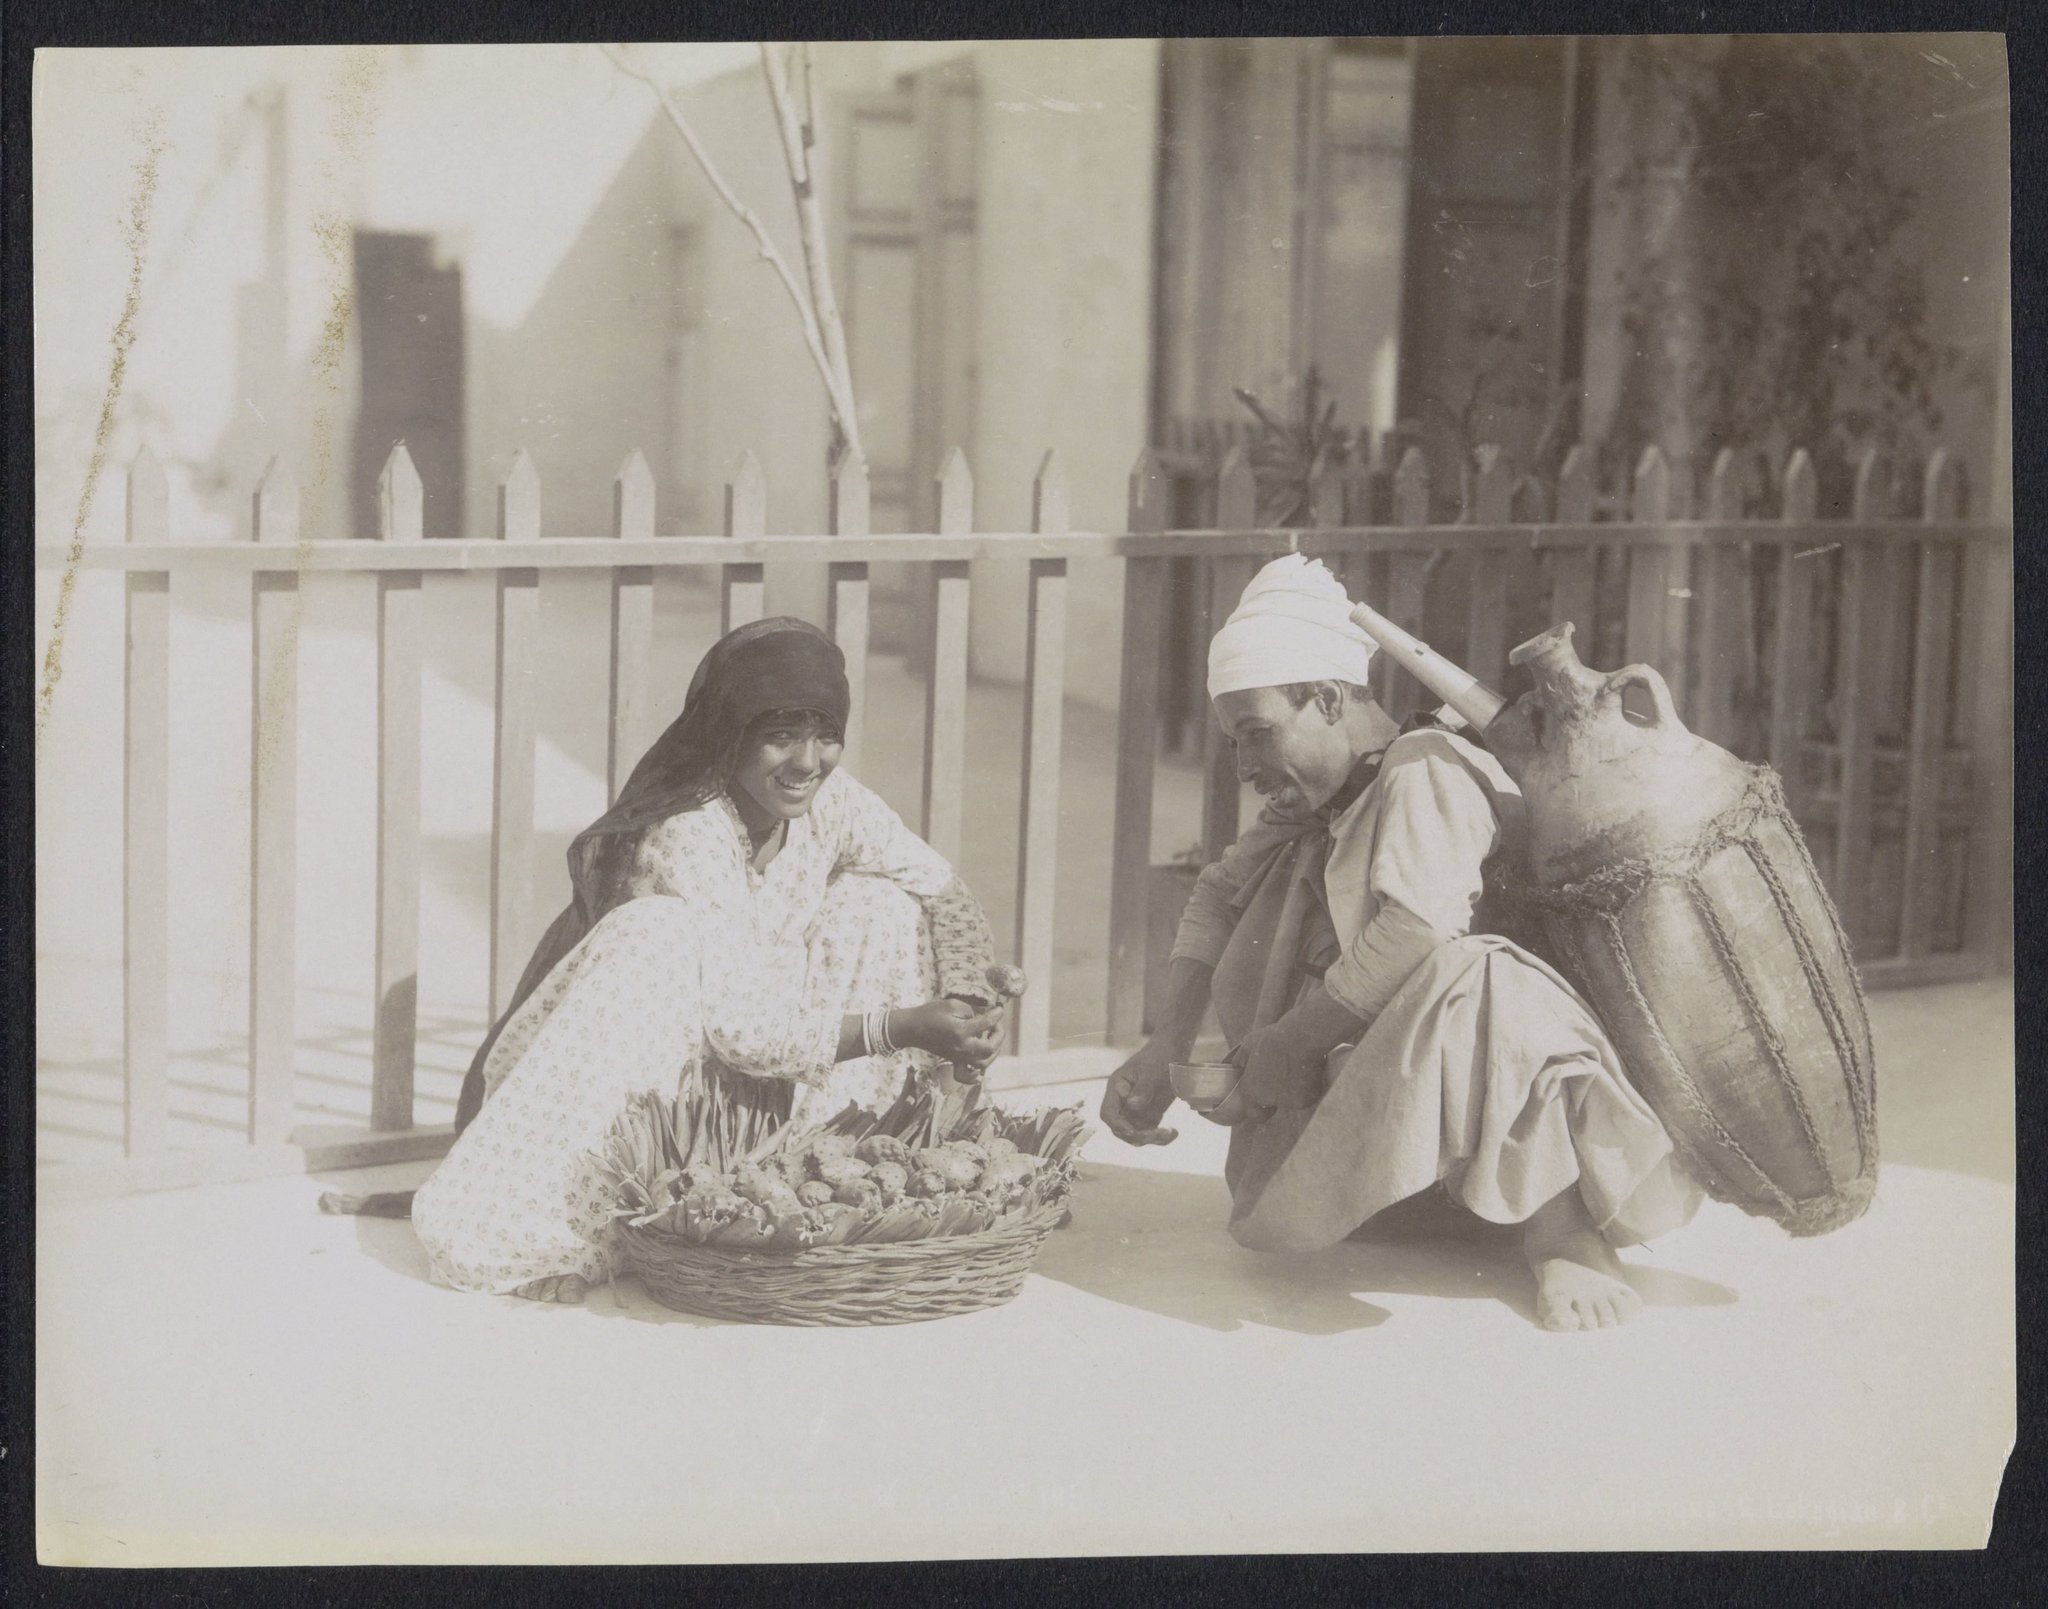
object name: photograph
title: Straatverkopers, mogelijk in Egypte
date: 1887-1925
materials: paper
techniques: albumen print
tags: street-trader - bb - women engaged in trade and commerce, street-trader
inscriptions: title: ‘[...]’